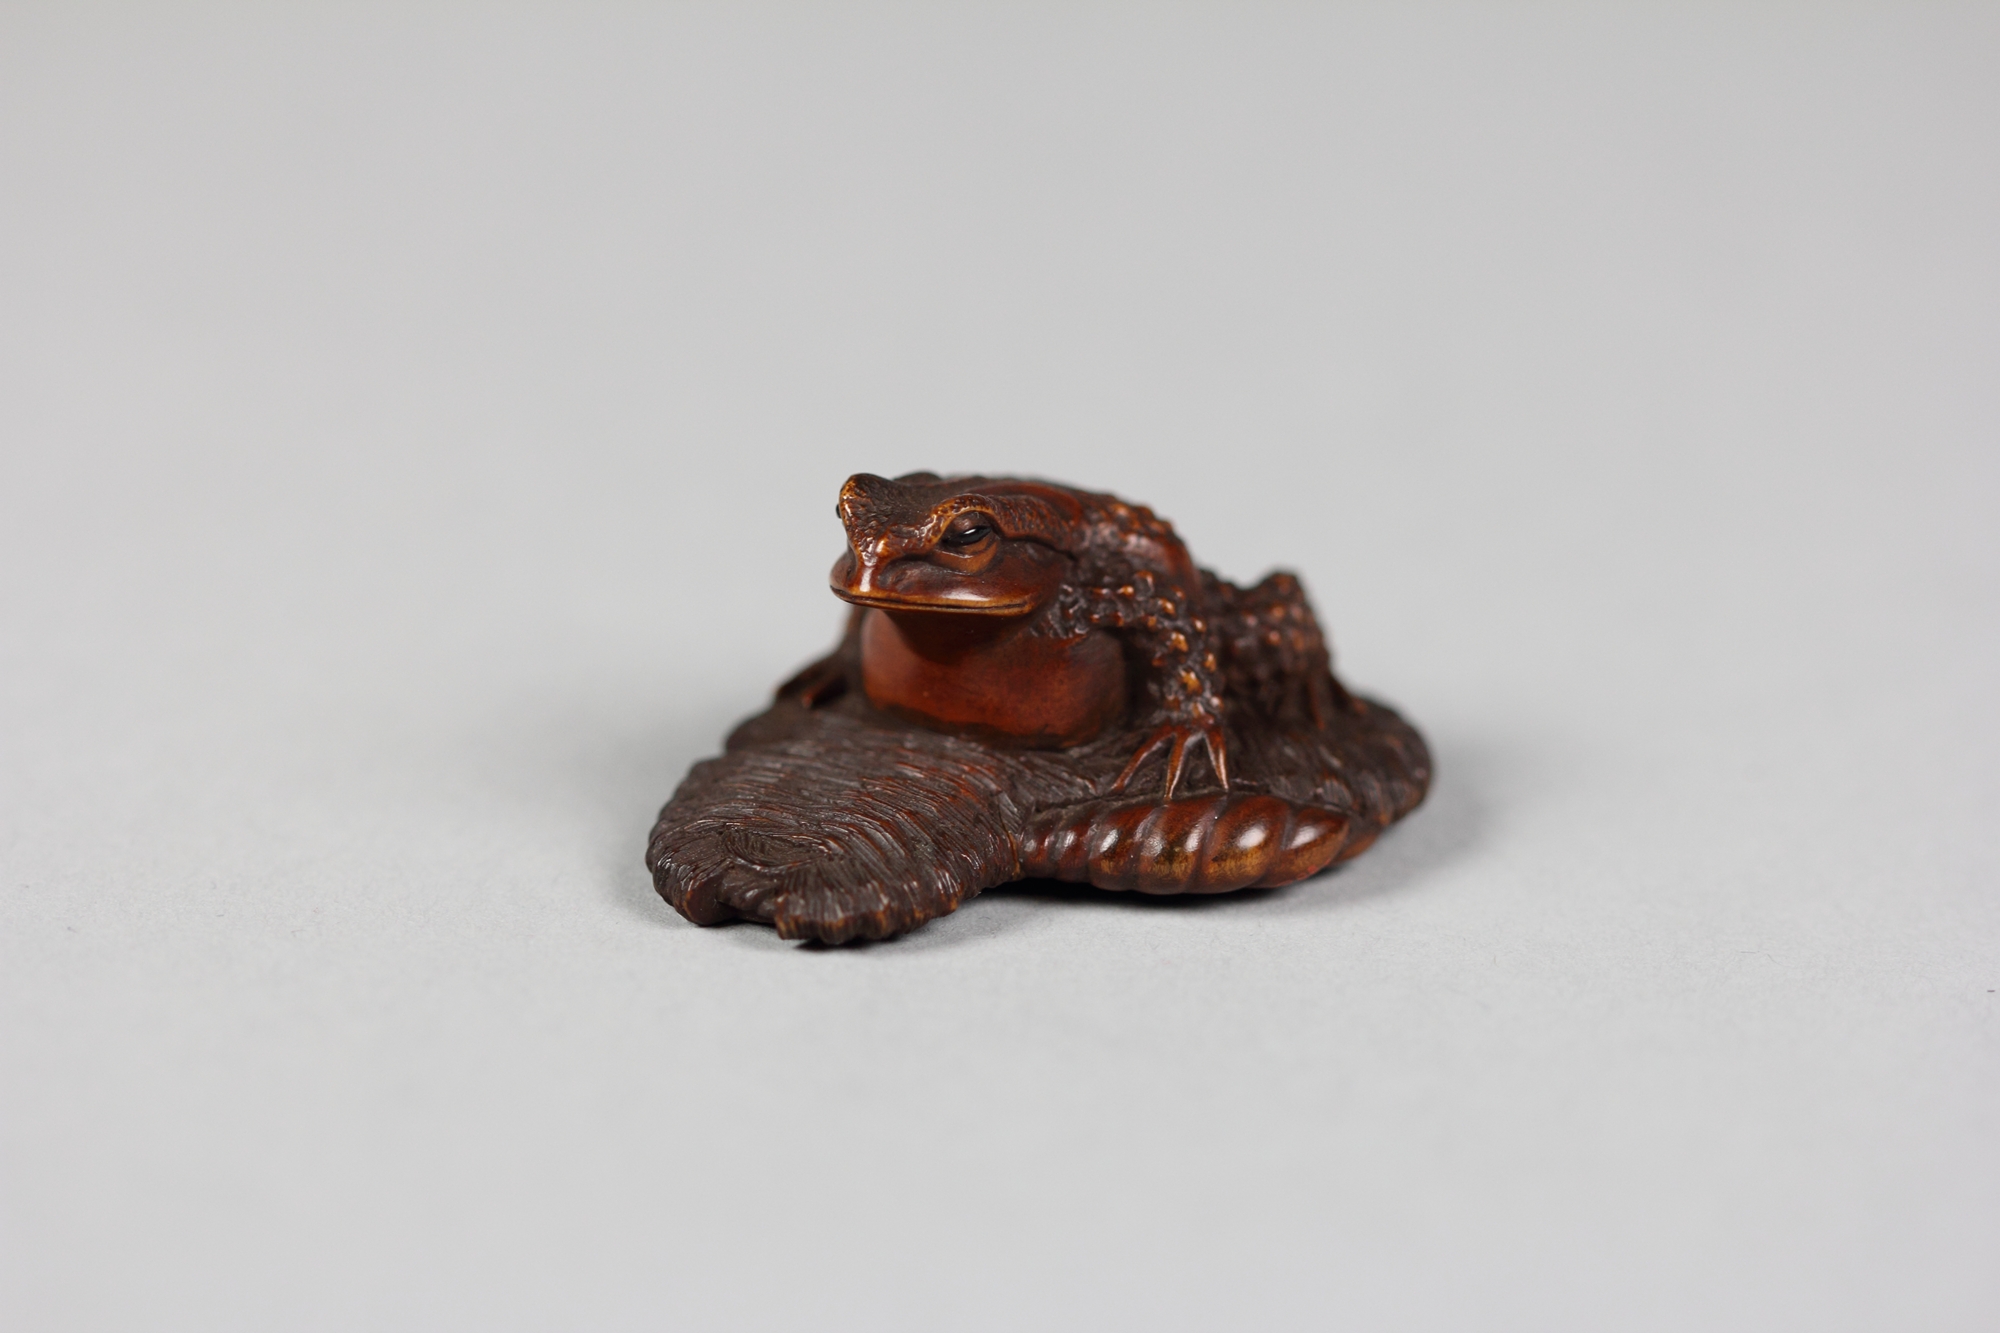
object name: netsuke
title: Netsuke of Frog on a Leaf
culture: japanese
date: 1801-1900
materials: wood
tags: frogs